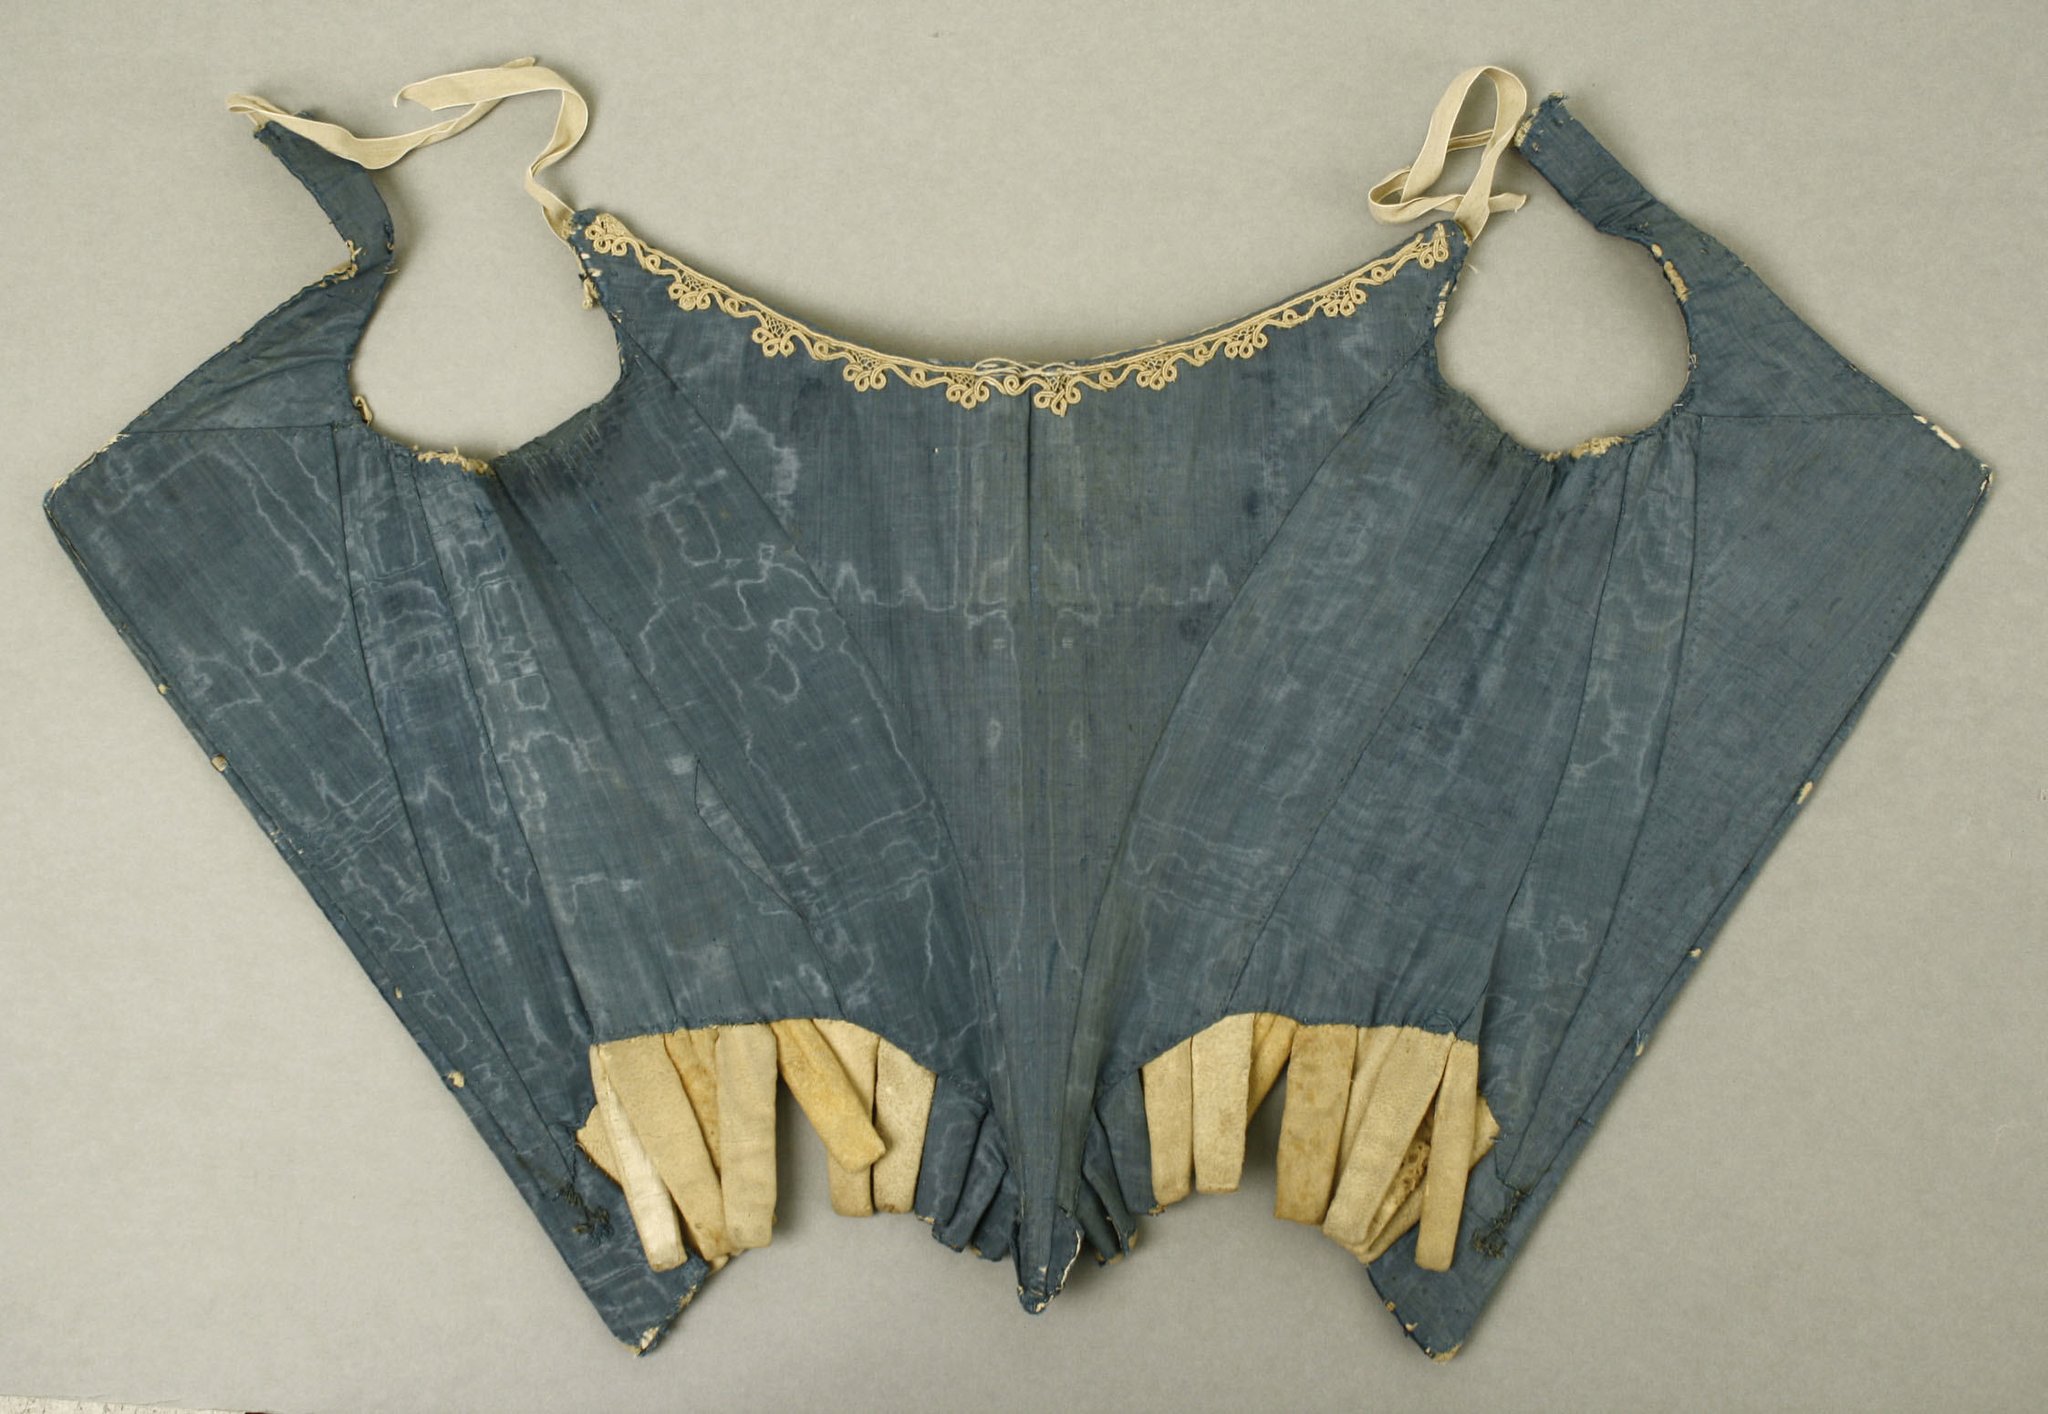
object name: stay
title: Stays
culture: british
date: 1767-1800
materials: silk